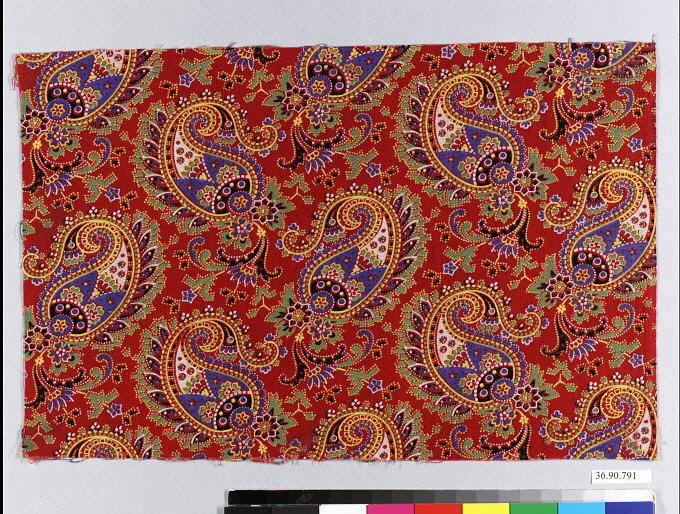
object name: piece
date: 1867-1900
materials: cotton